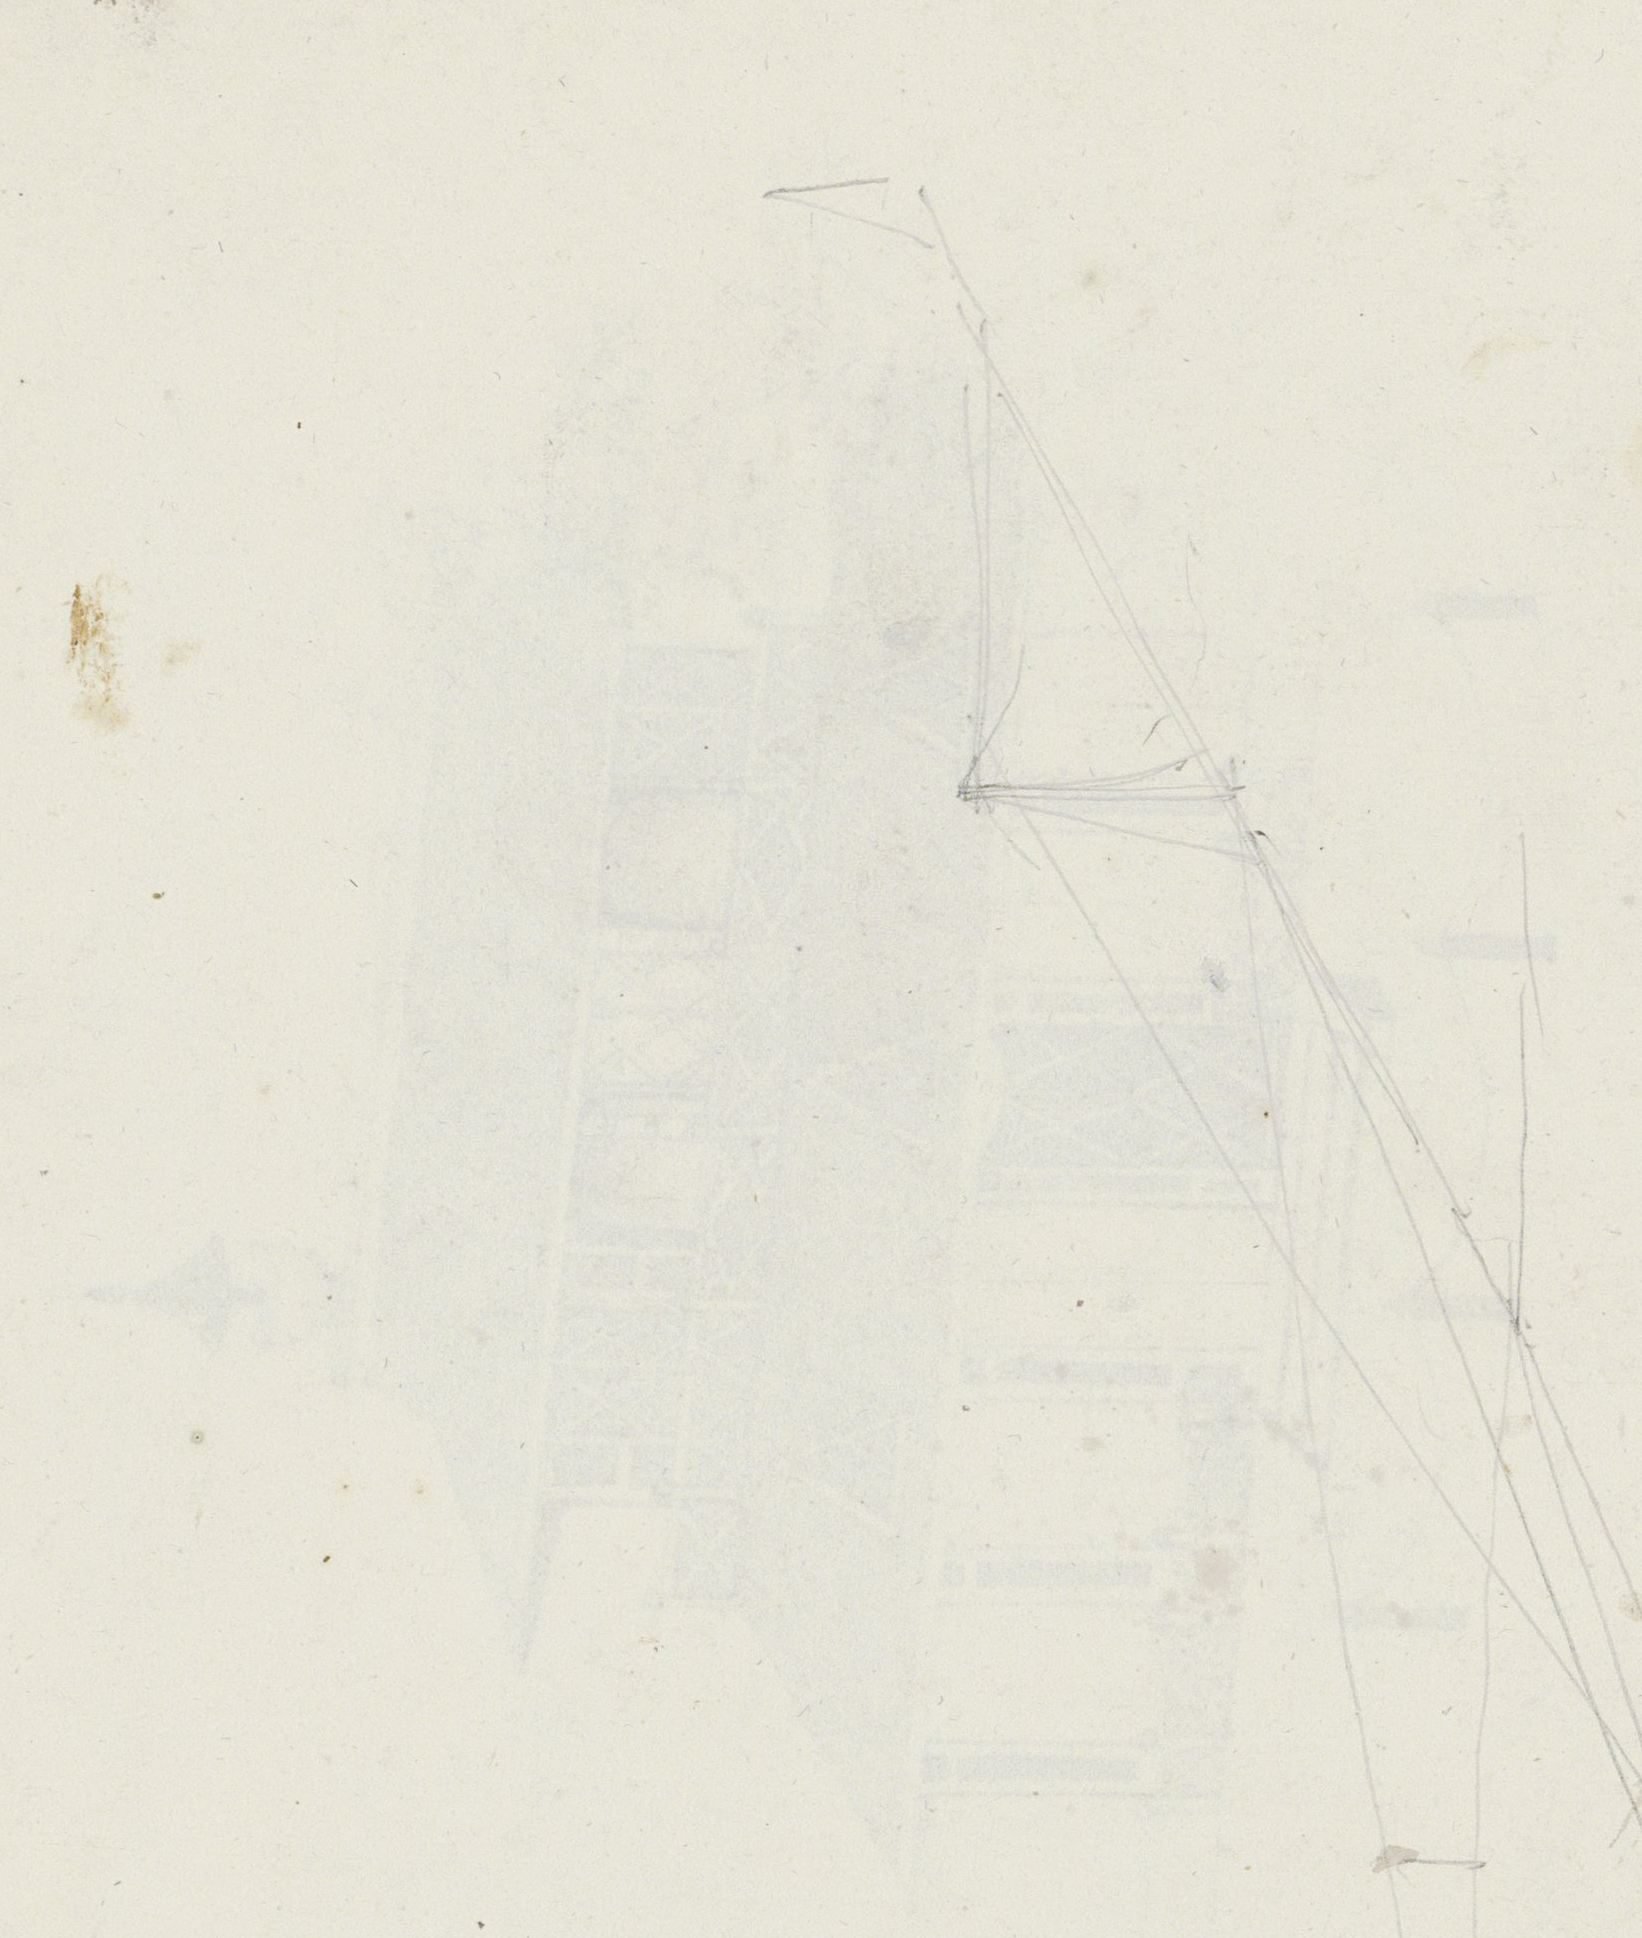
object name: sketchbook leaf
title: Studie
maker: jonkvrouw elisabeth kemper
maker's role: draughtsman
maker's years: 1799-1871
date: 1815-1852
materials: paper, pencil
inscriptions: annotation: ‘huis Peking te Baarn’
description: Verso van een losse tekening tussen blad 94 en het achterste schutblad uit een schetsboek met 94 bladen.